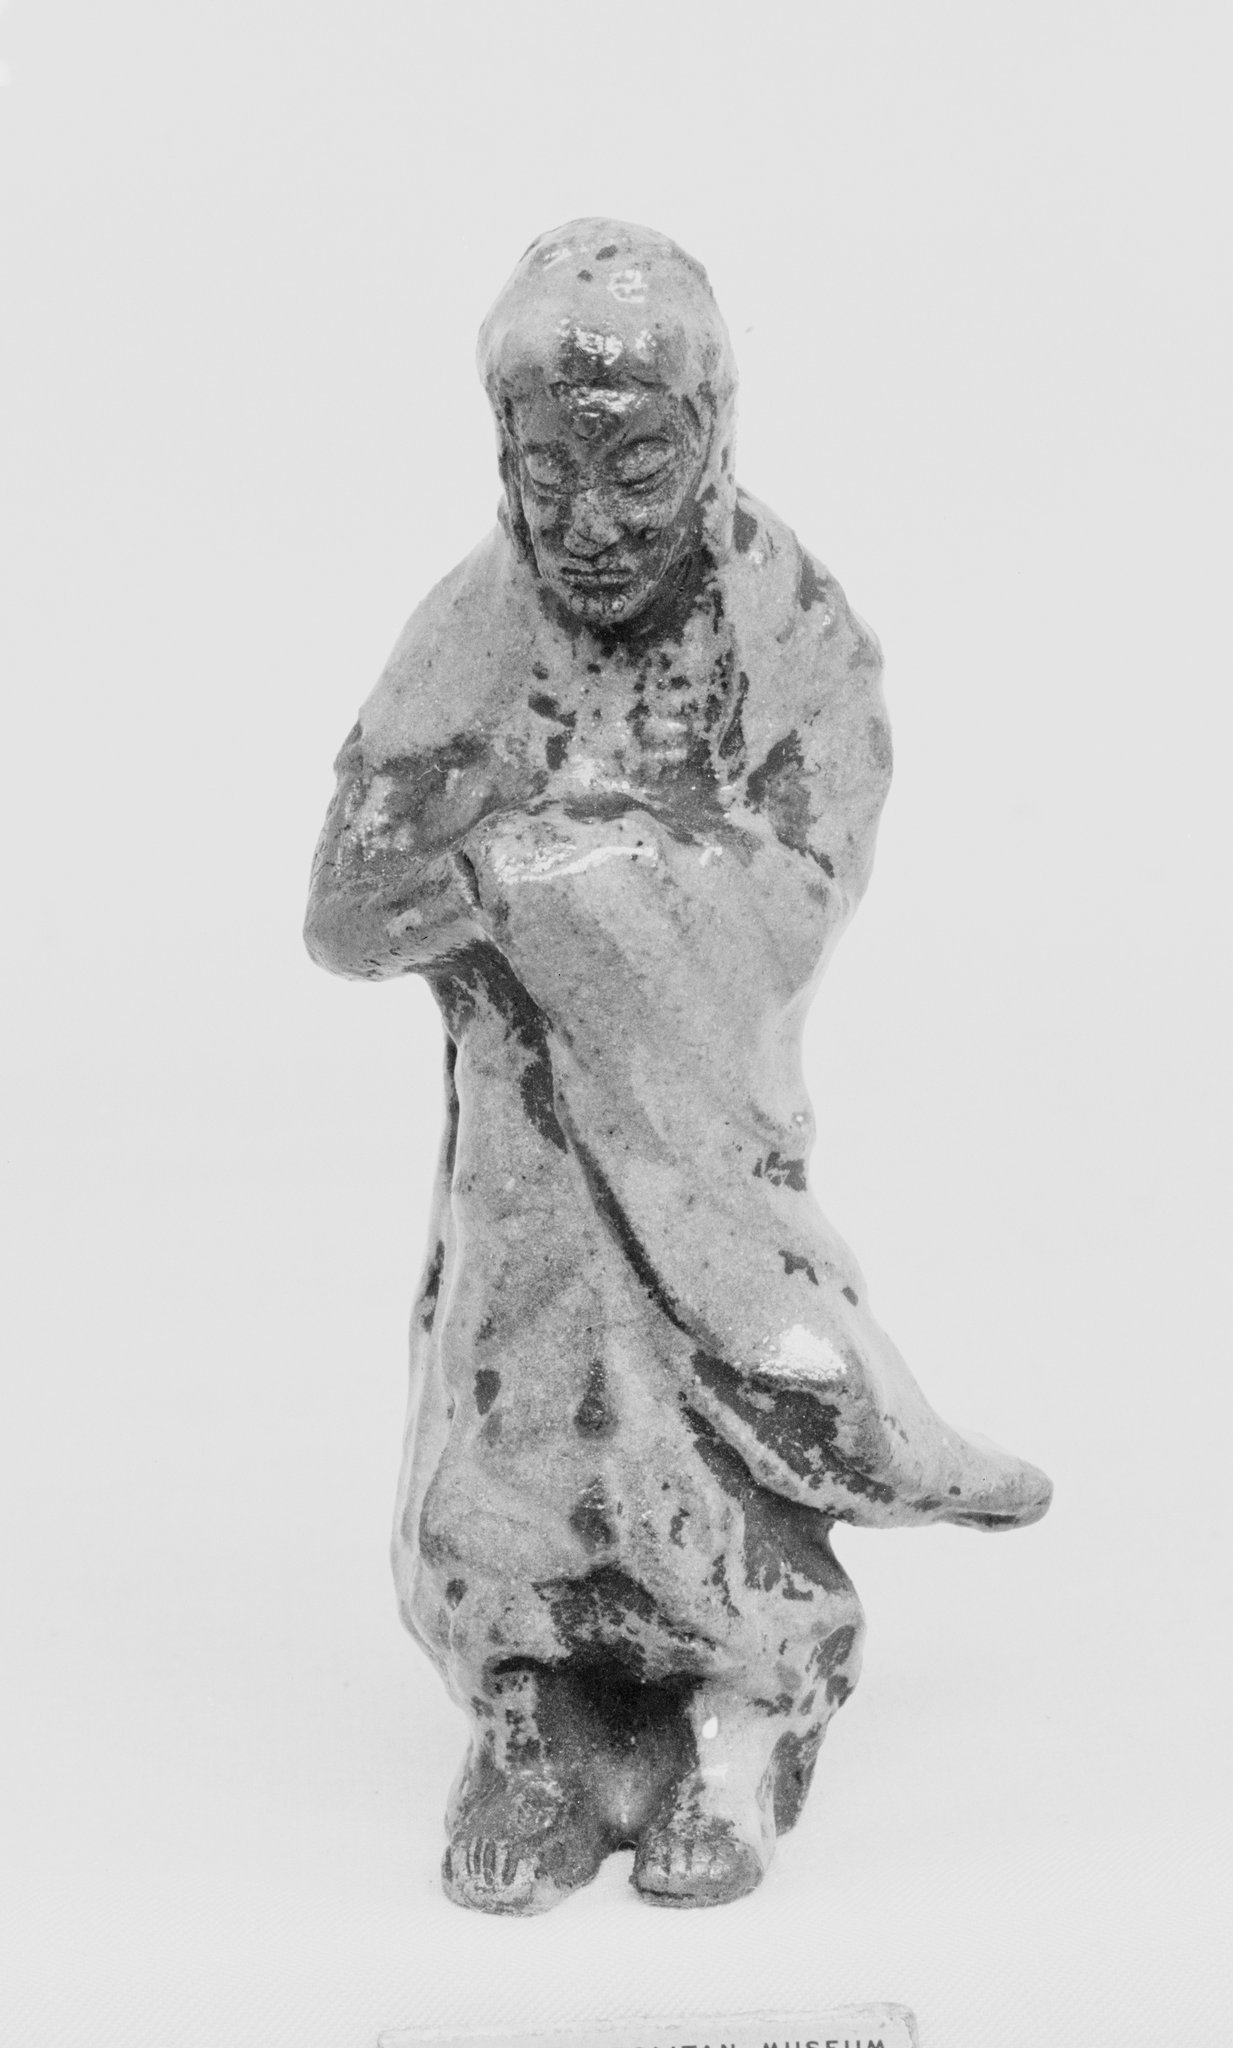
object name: figure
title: Figure of a Rakan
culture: japanese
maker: dr. bunkio masaki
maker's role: artist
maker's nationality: japanese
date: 1801-1900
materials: glaze, paste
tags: men